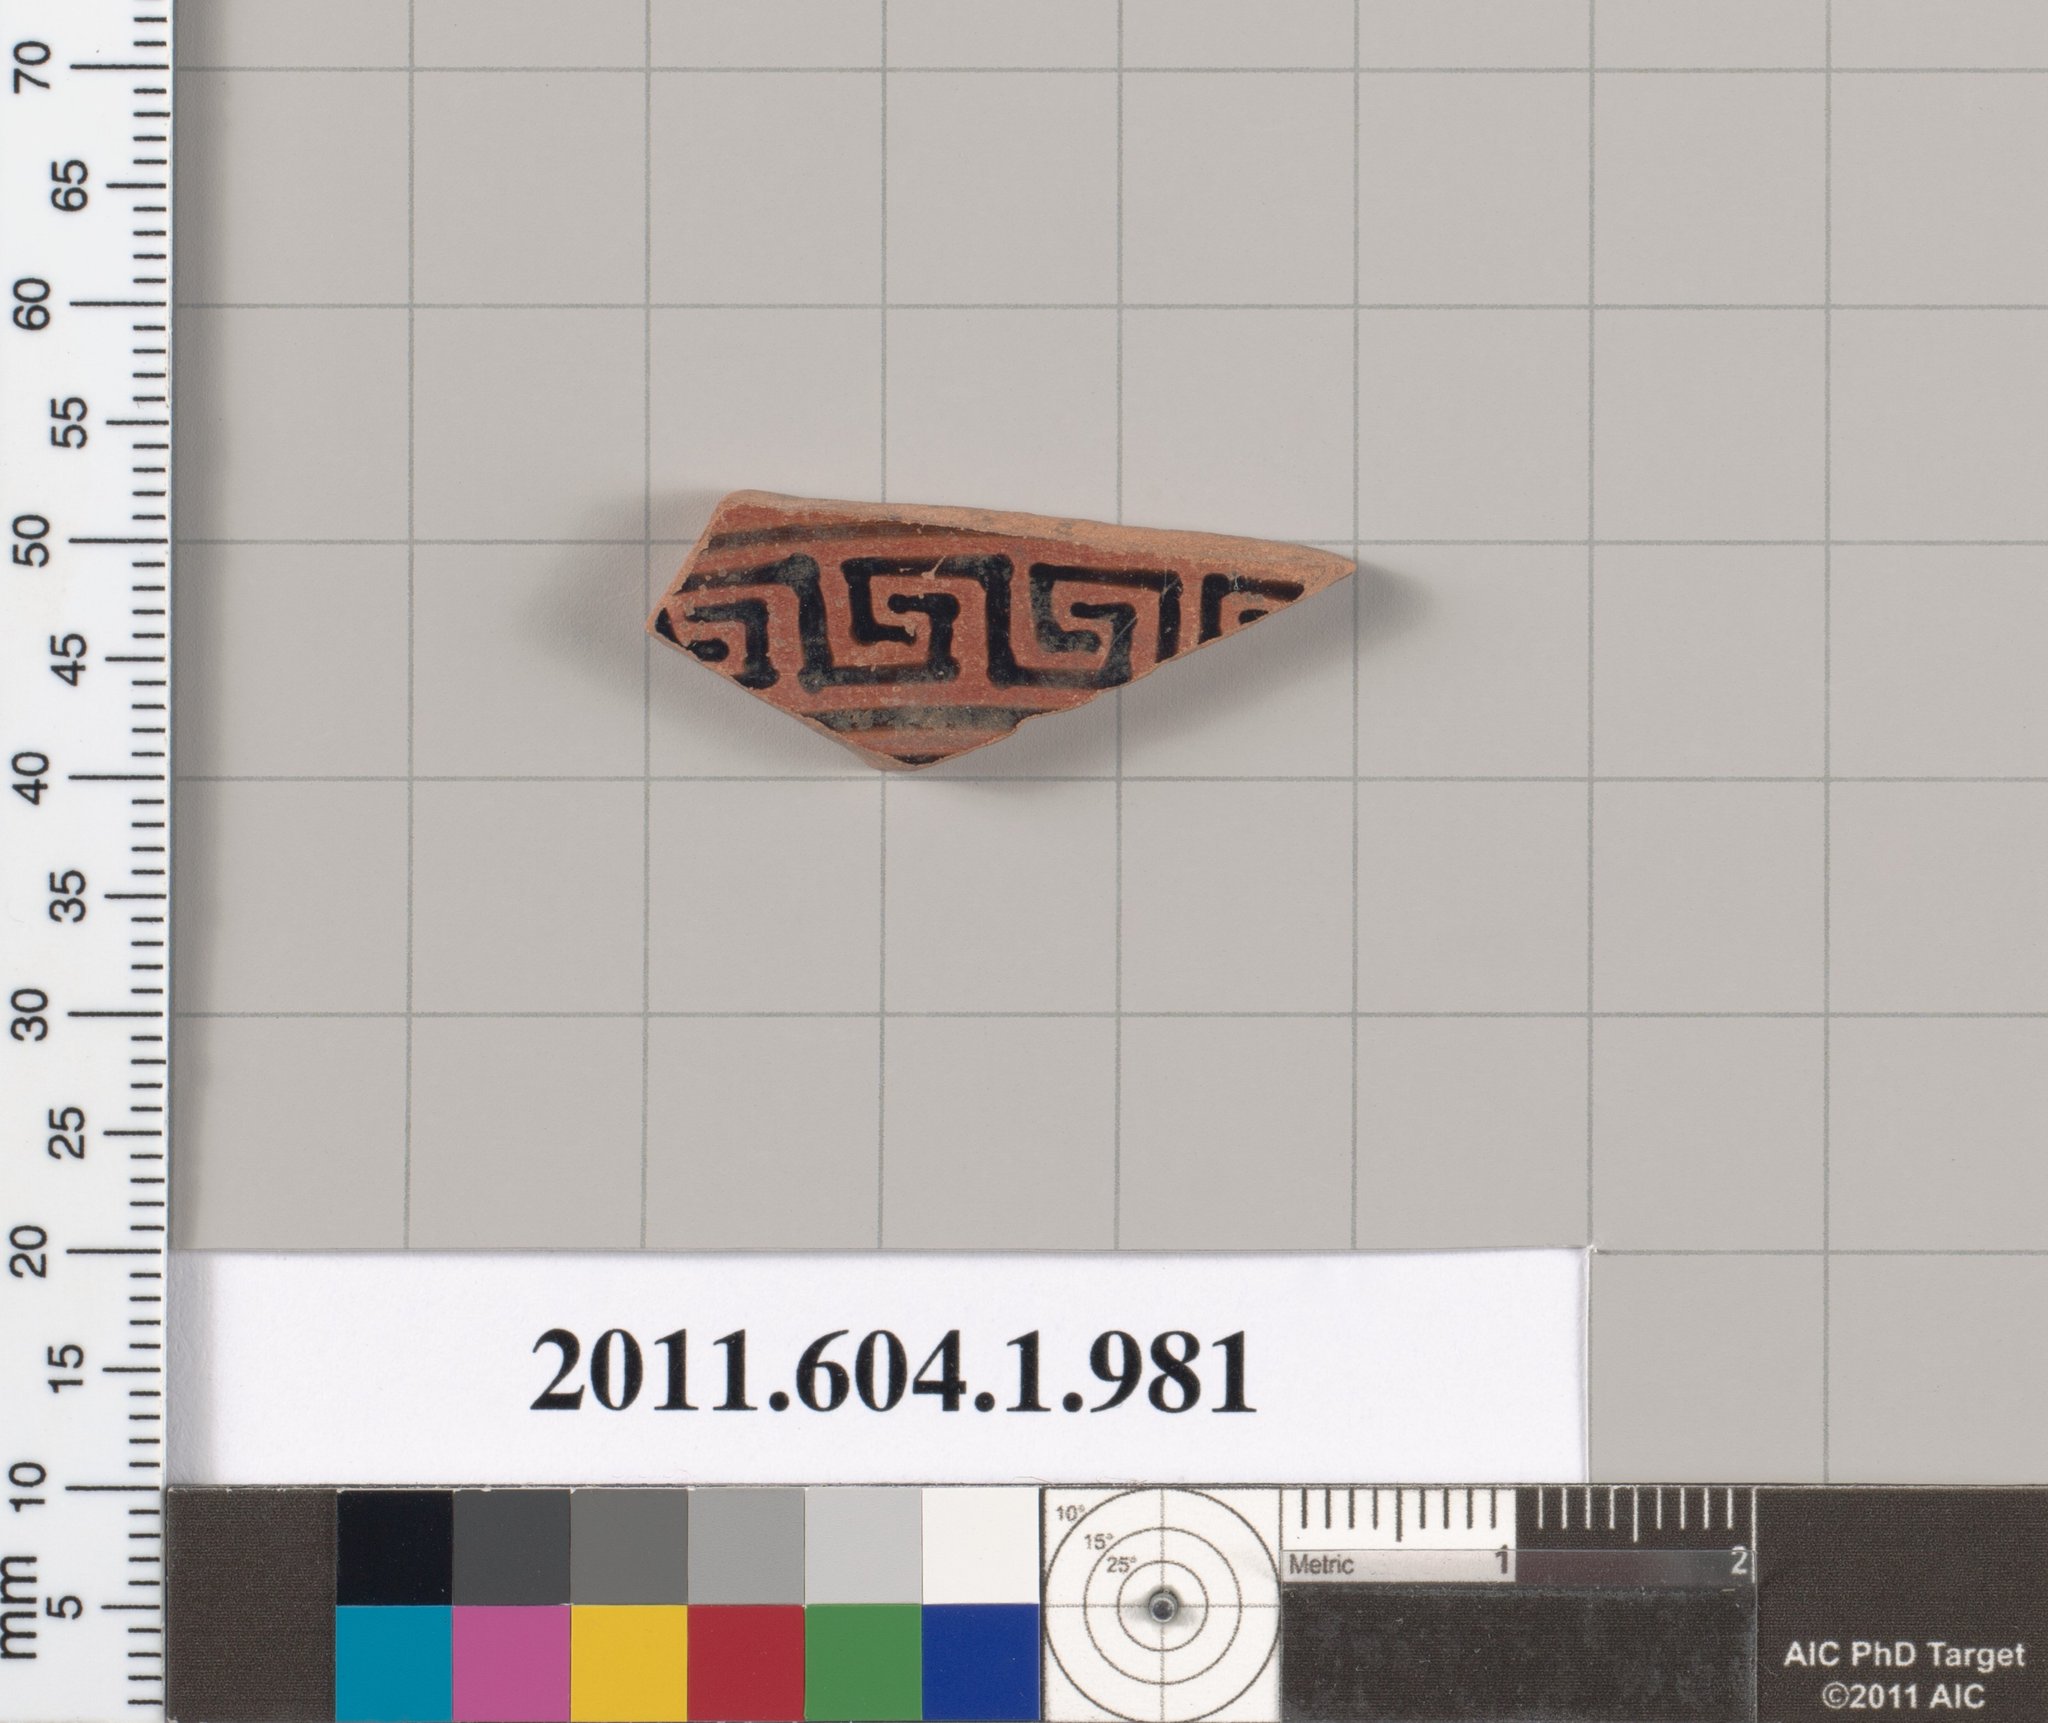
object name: kylix fragment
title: Terracotta fragment of a kylix (drinking cup)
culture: greek, attic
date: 490-480 BCE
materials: terracotta